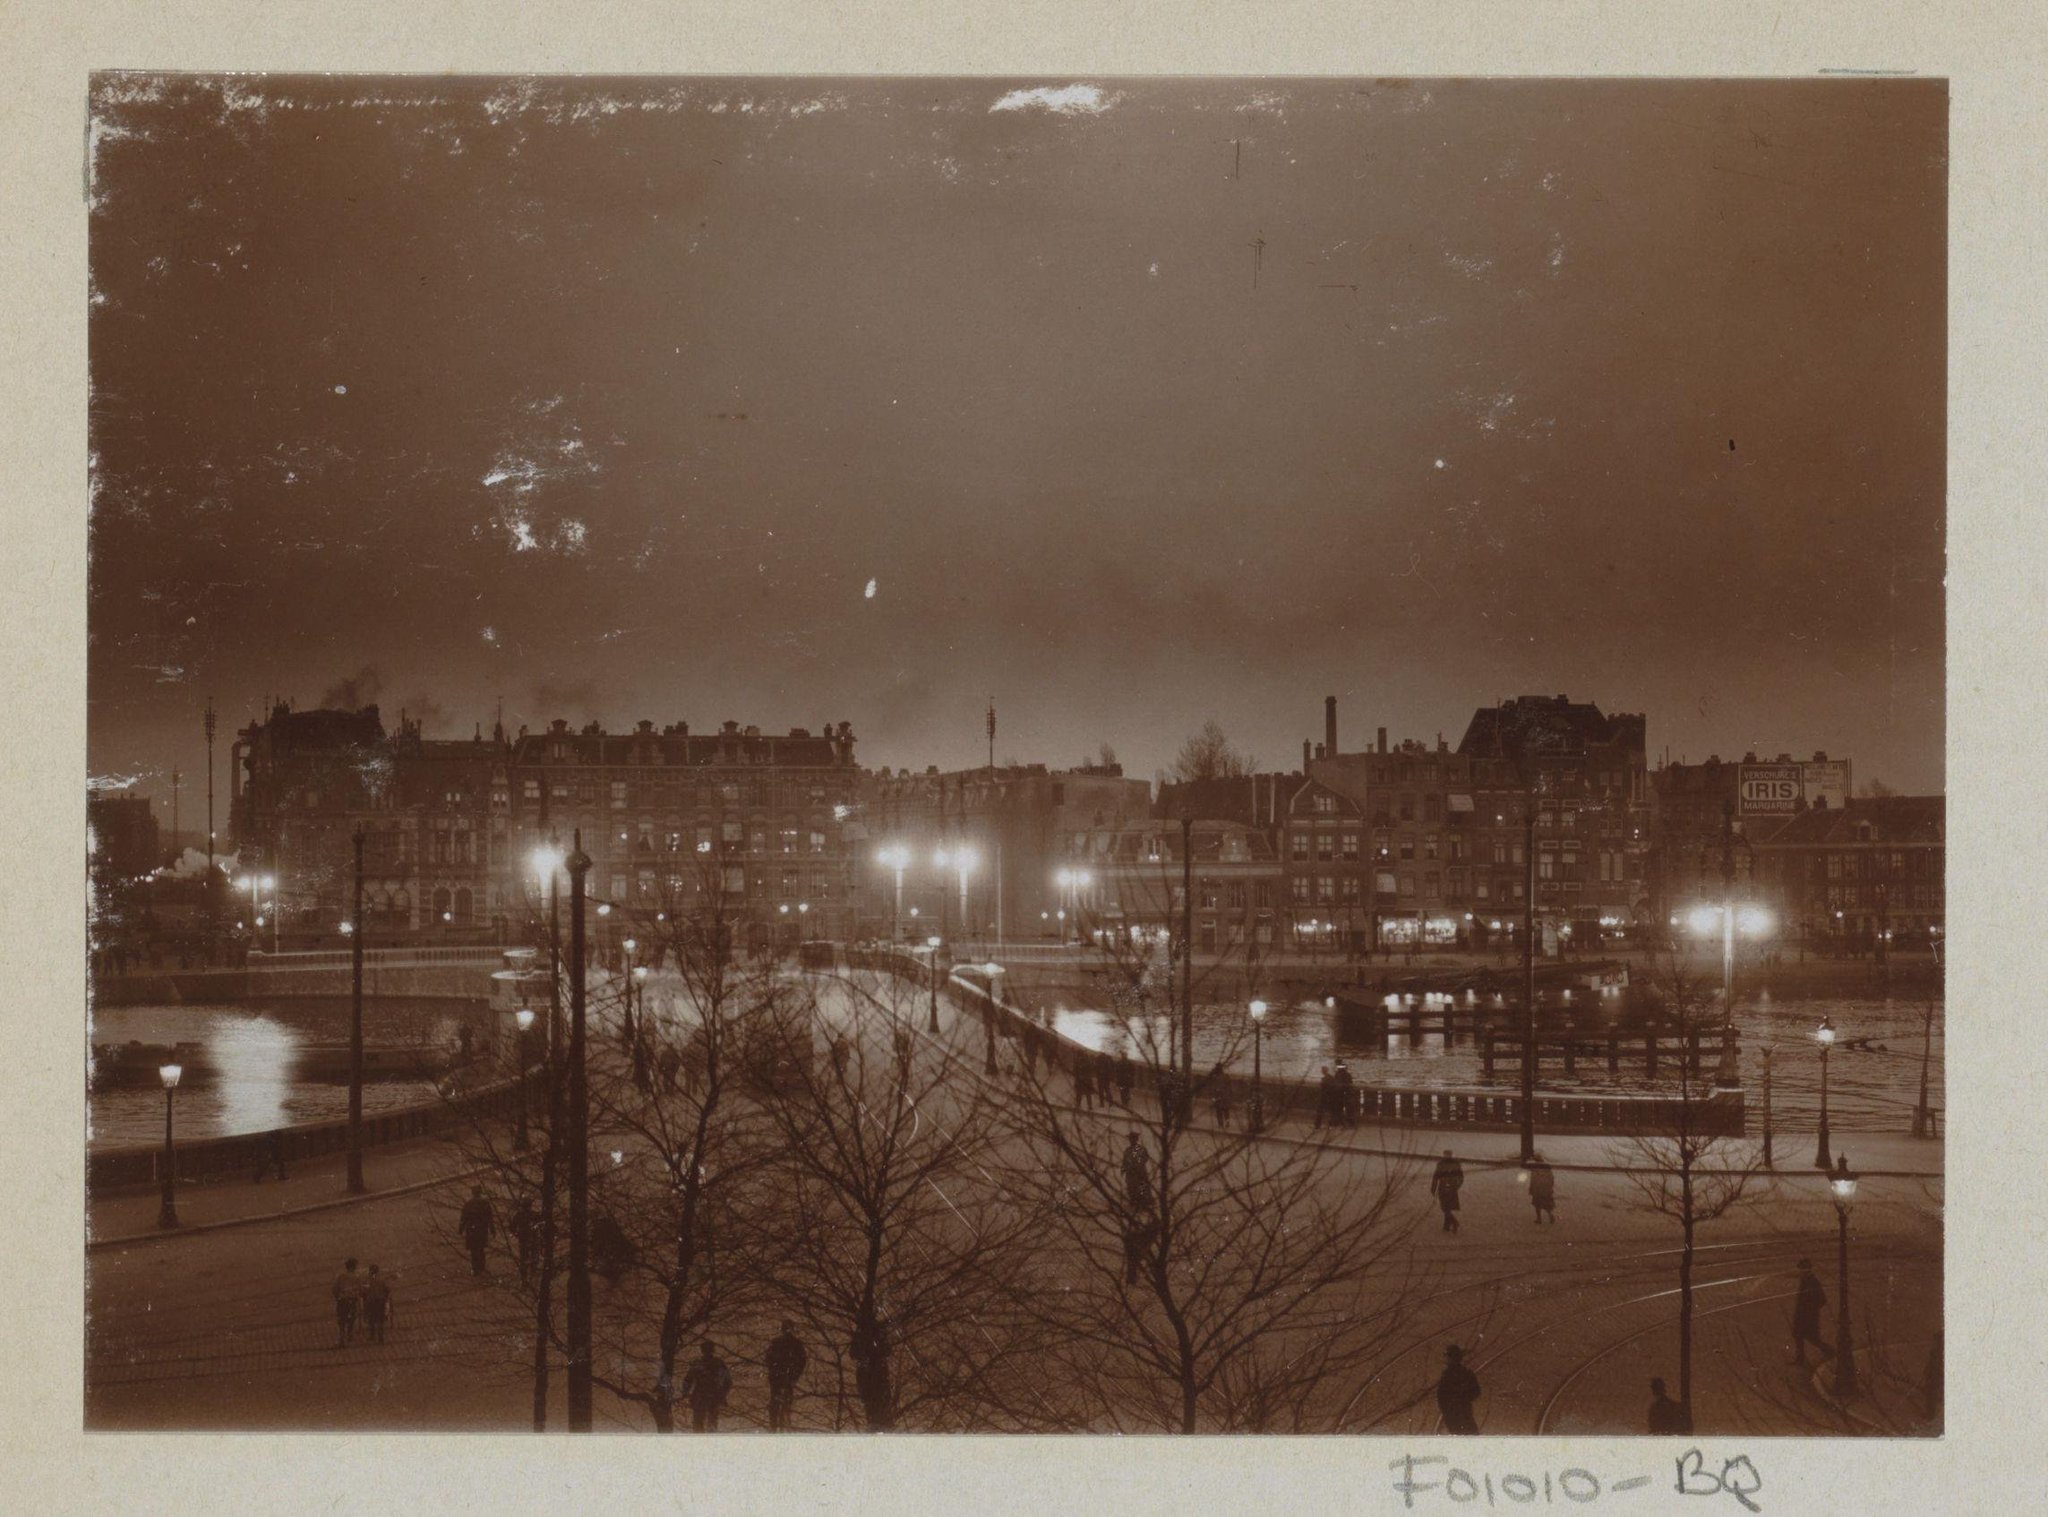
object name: photograph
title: Gezicht op de Nieuwe Amstelbrug bij avond, richting Amsterdam-Oost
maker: Anonymous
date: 1903-1910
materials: photographic support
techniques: collodion silver print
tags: river, bridge, night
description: Onderdeel van Familiealbum met onder meer foto's van Wijnhandel Kraaij & Co. Bordeaux-Amsterdam.